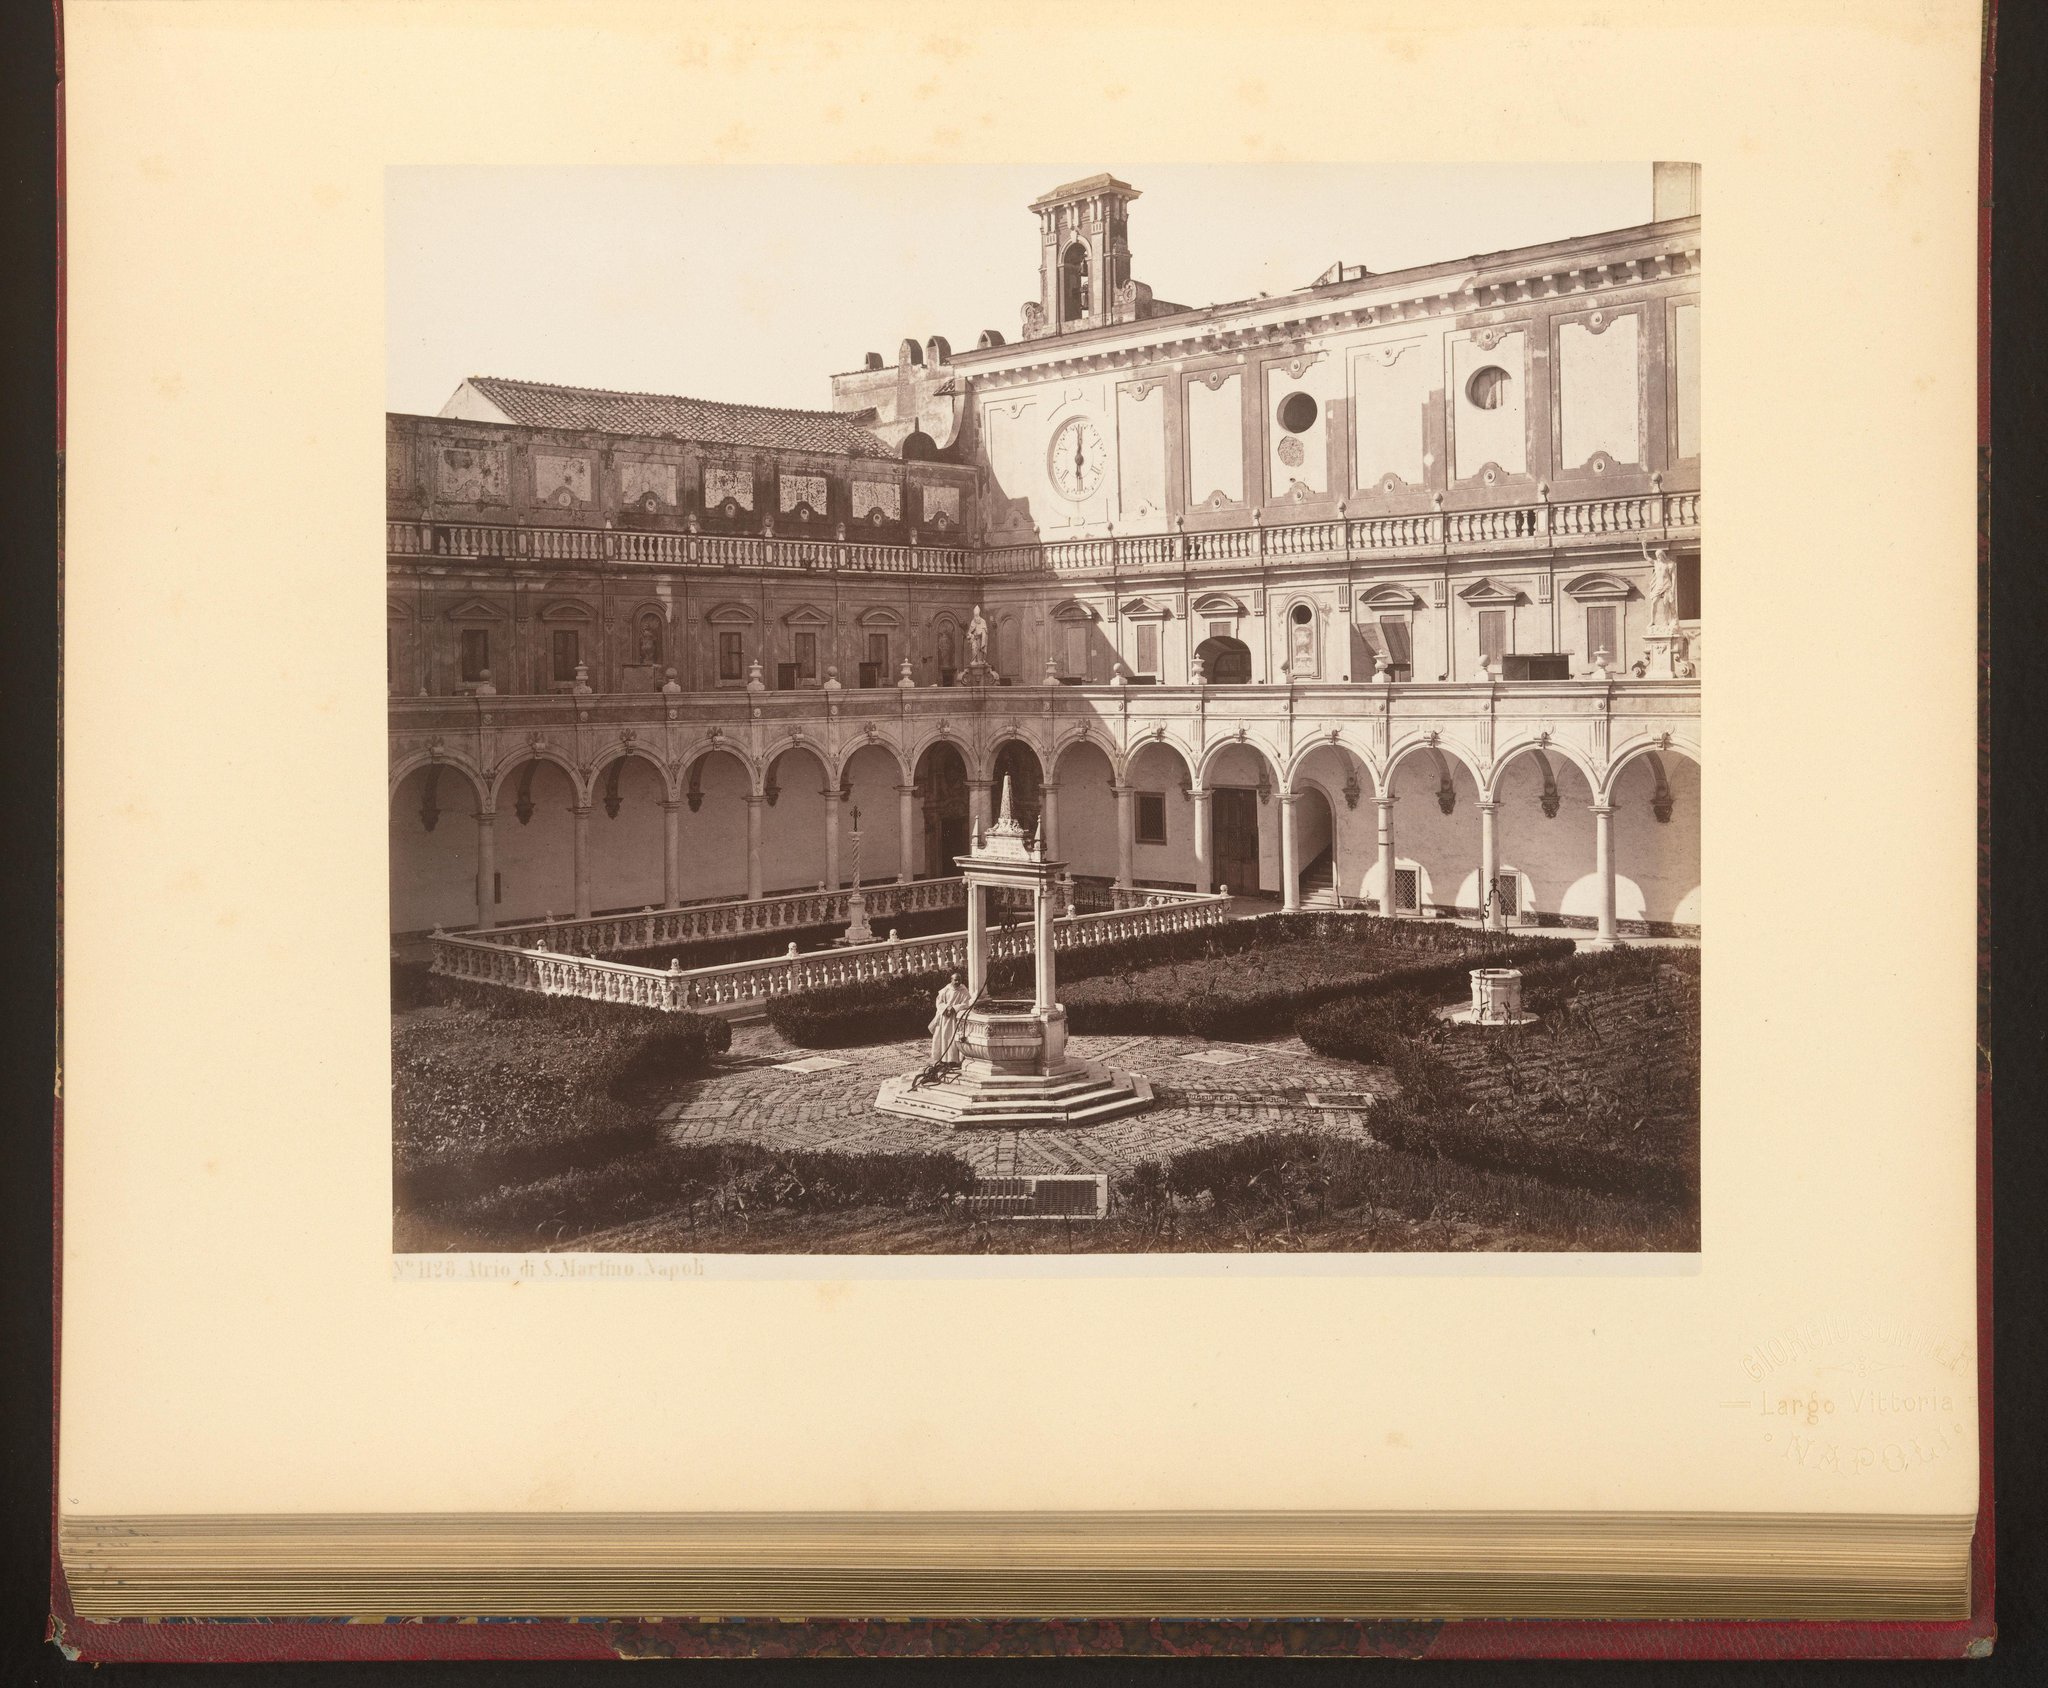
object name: album leaf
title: Atrio di San Martino. Napoli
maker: giorgio sommer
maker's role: fotograaf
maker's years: 1834-1914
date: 1874-1879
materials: photographic support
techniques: albumen print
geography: naples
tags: façade of inner court, courtyard, naples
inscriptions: number: ‘1126’, workshop stamp: ‘Giorgio Sommer/ Largo Vittoria/ Napoli’